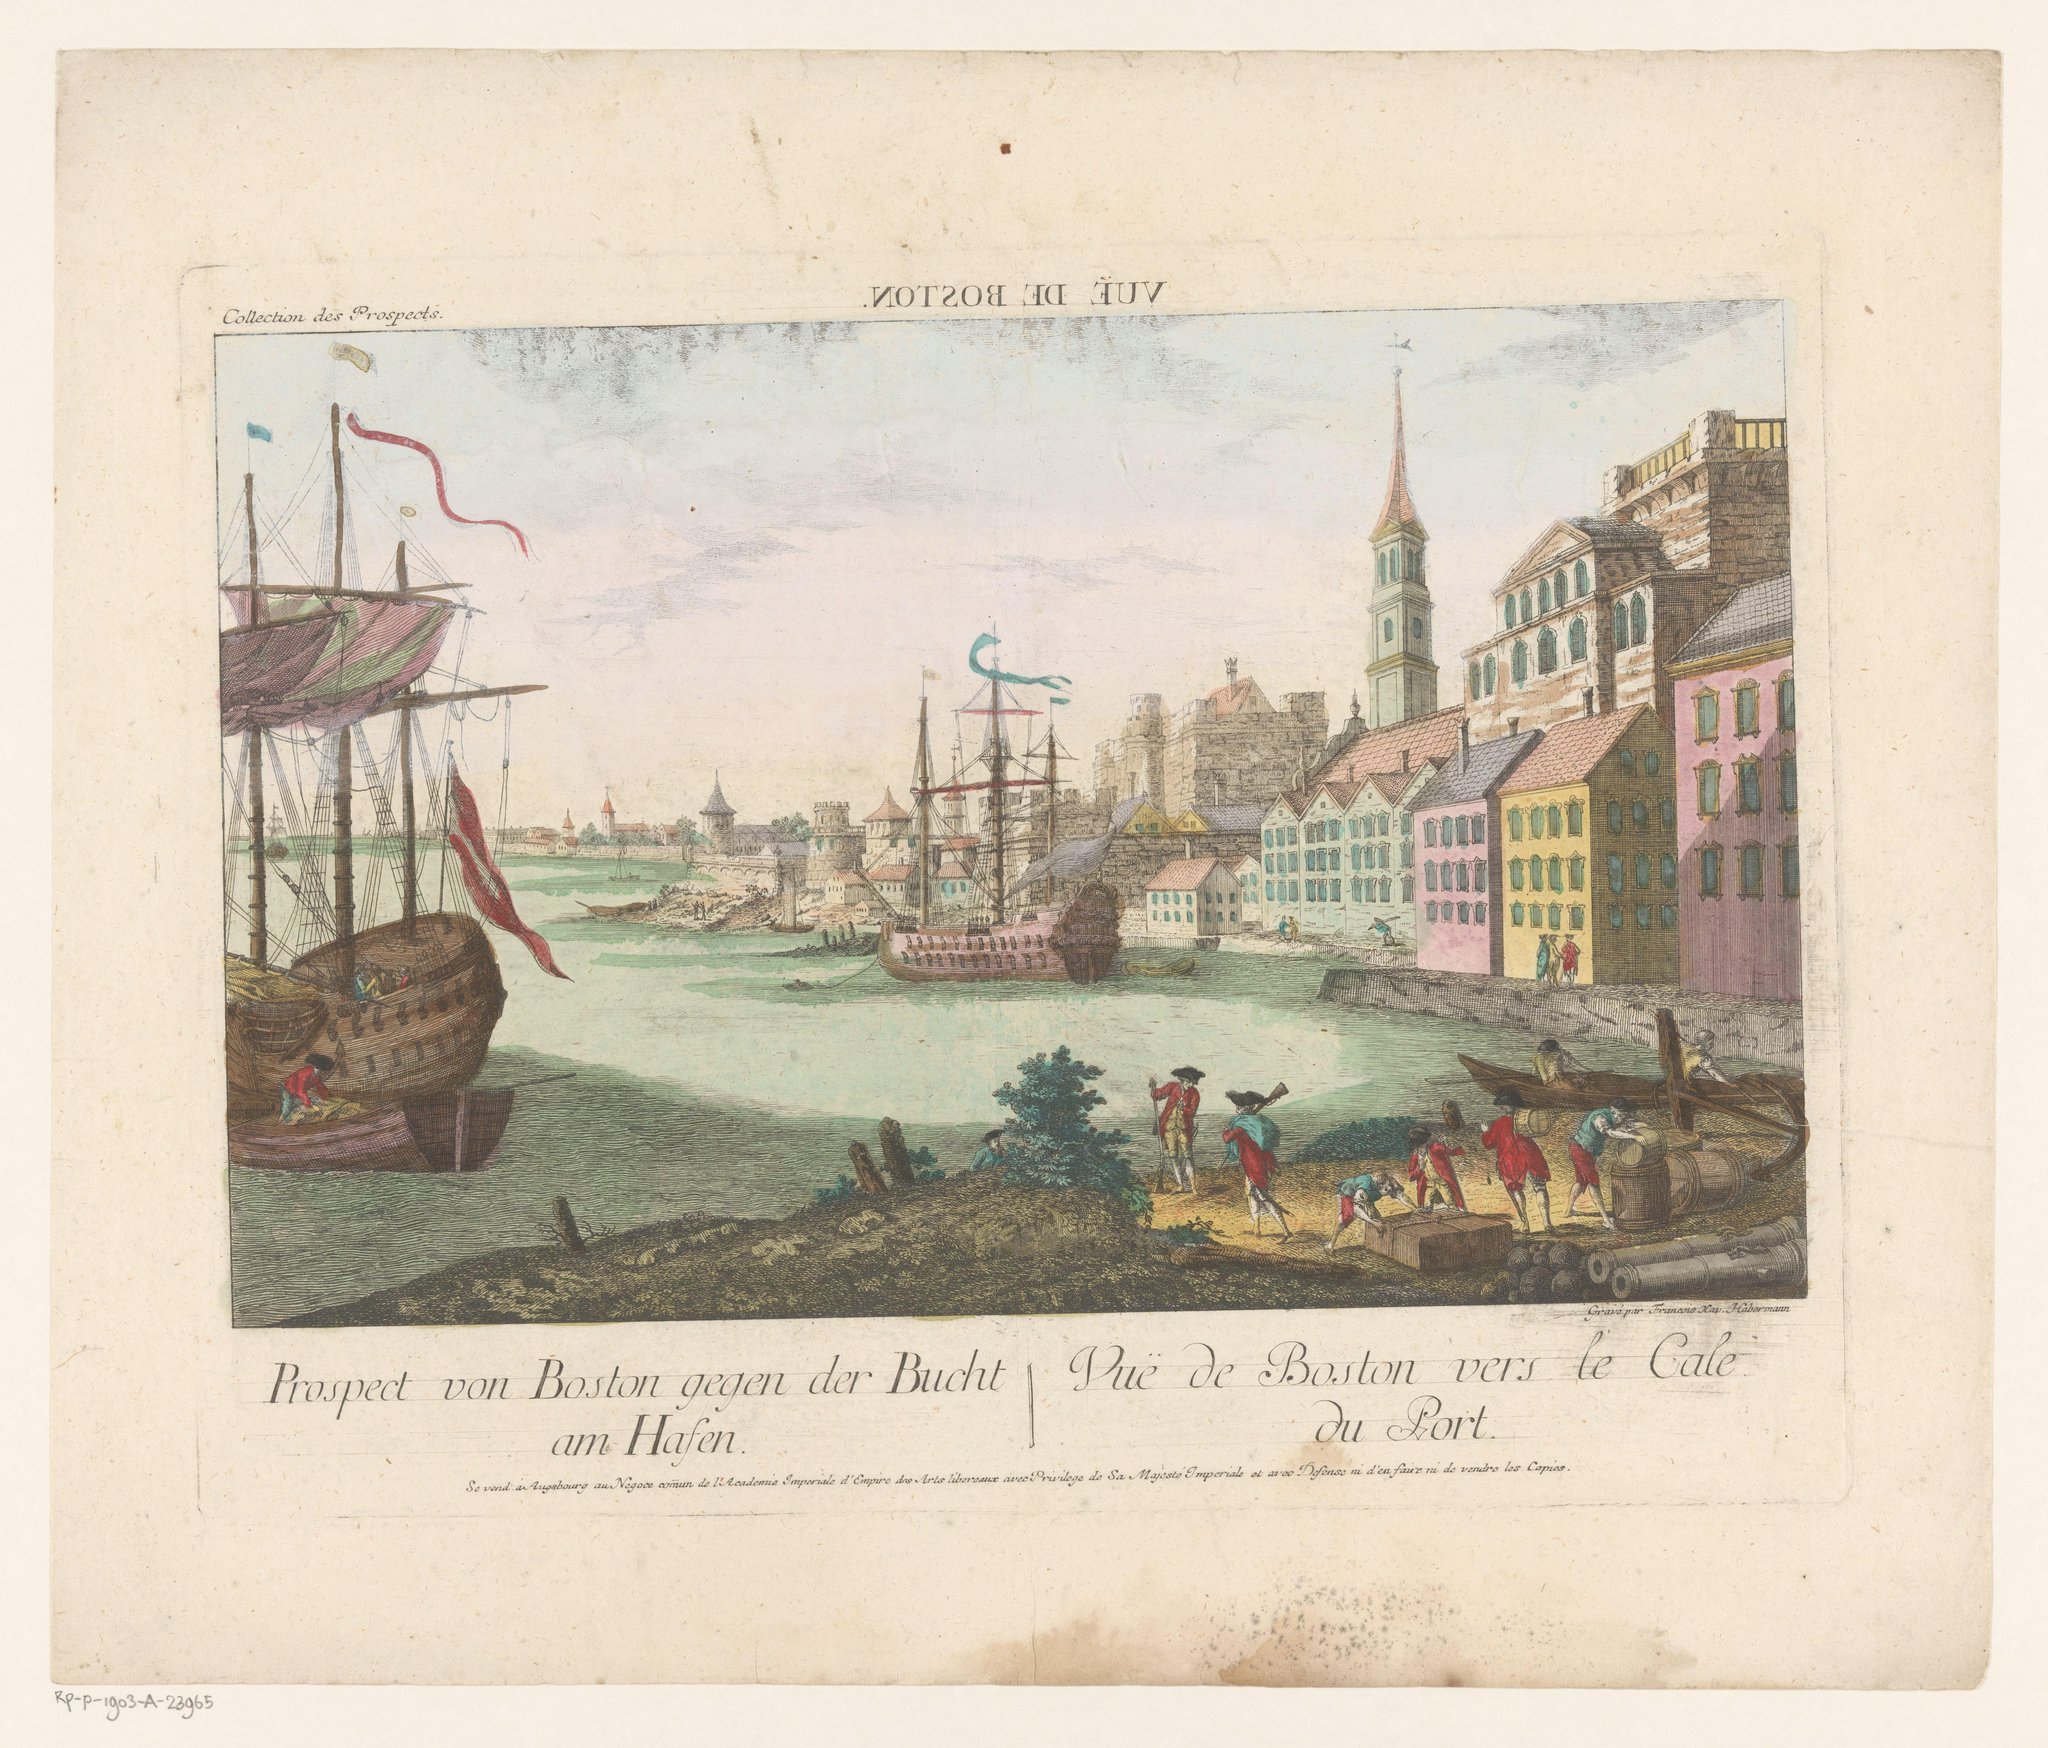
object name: print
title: Gezicht op de haven te Boston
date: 1755-1779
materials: paper, watercolor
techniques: brush, etching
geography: augsburg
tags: harbour, sailing-ship, sailing-boat, castle, rowing-boat, canoe, etc.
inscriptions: collector's mark: Lugt 2228